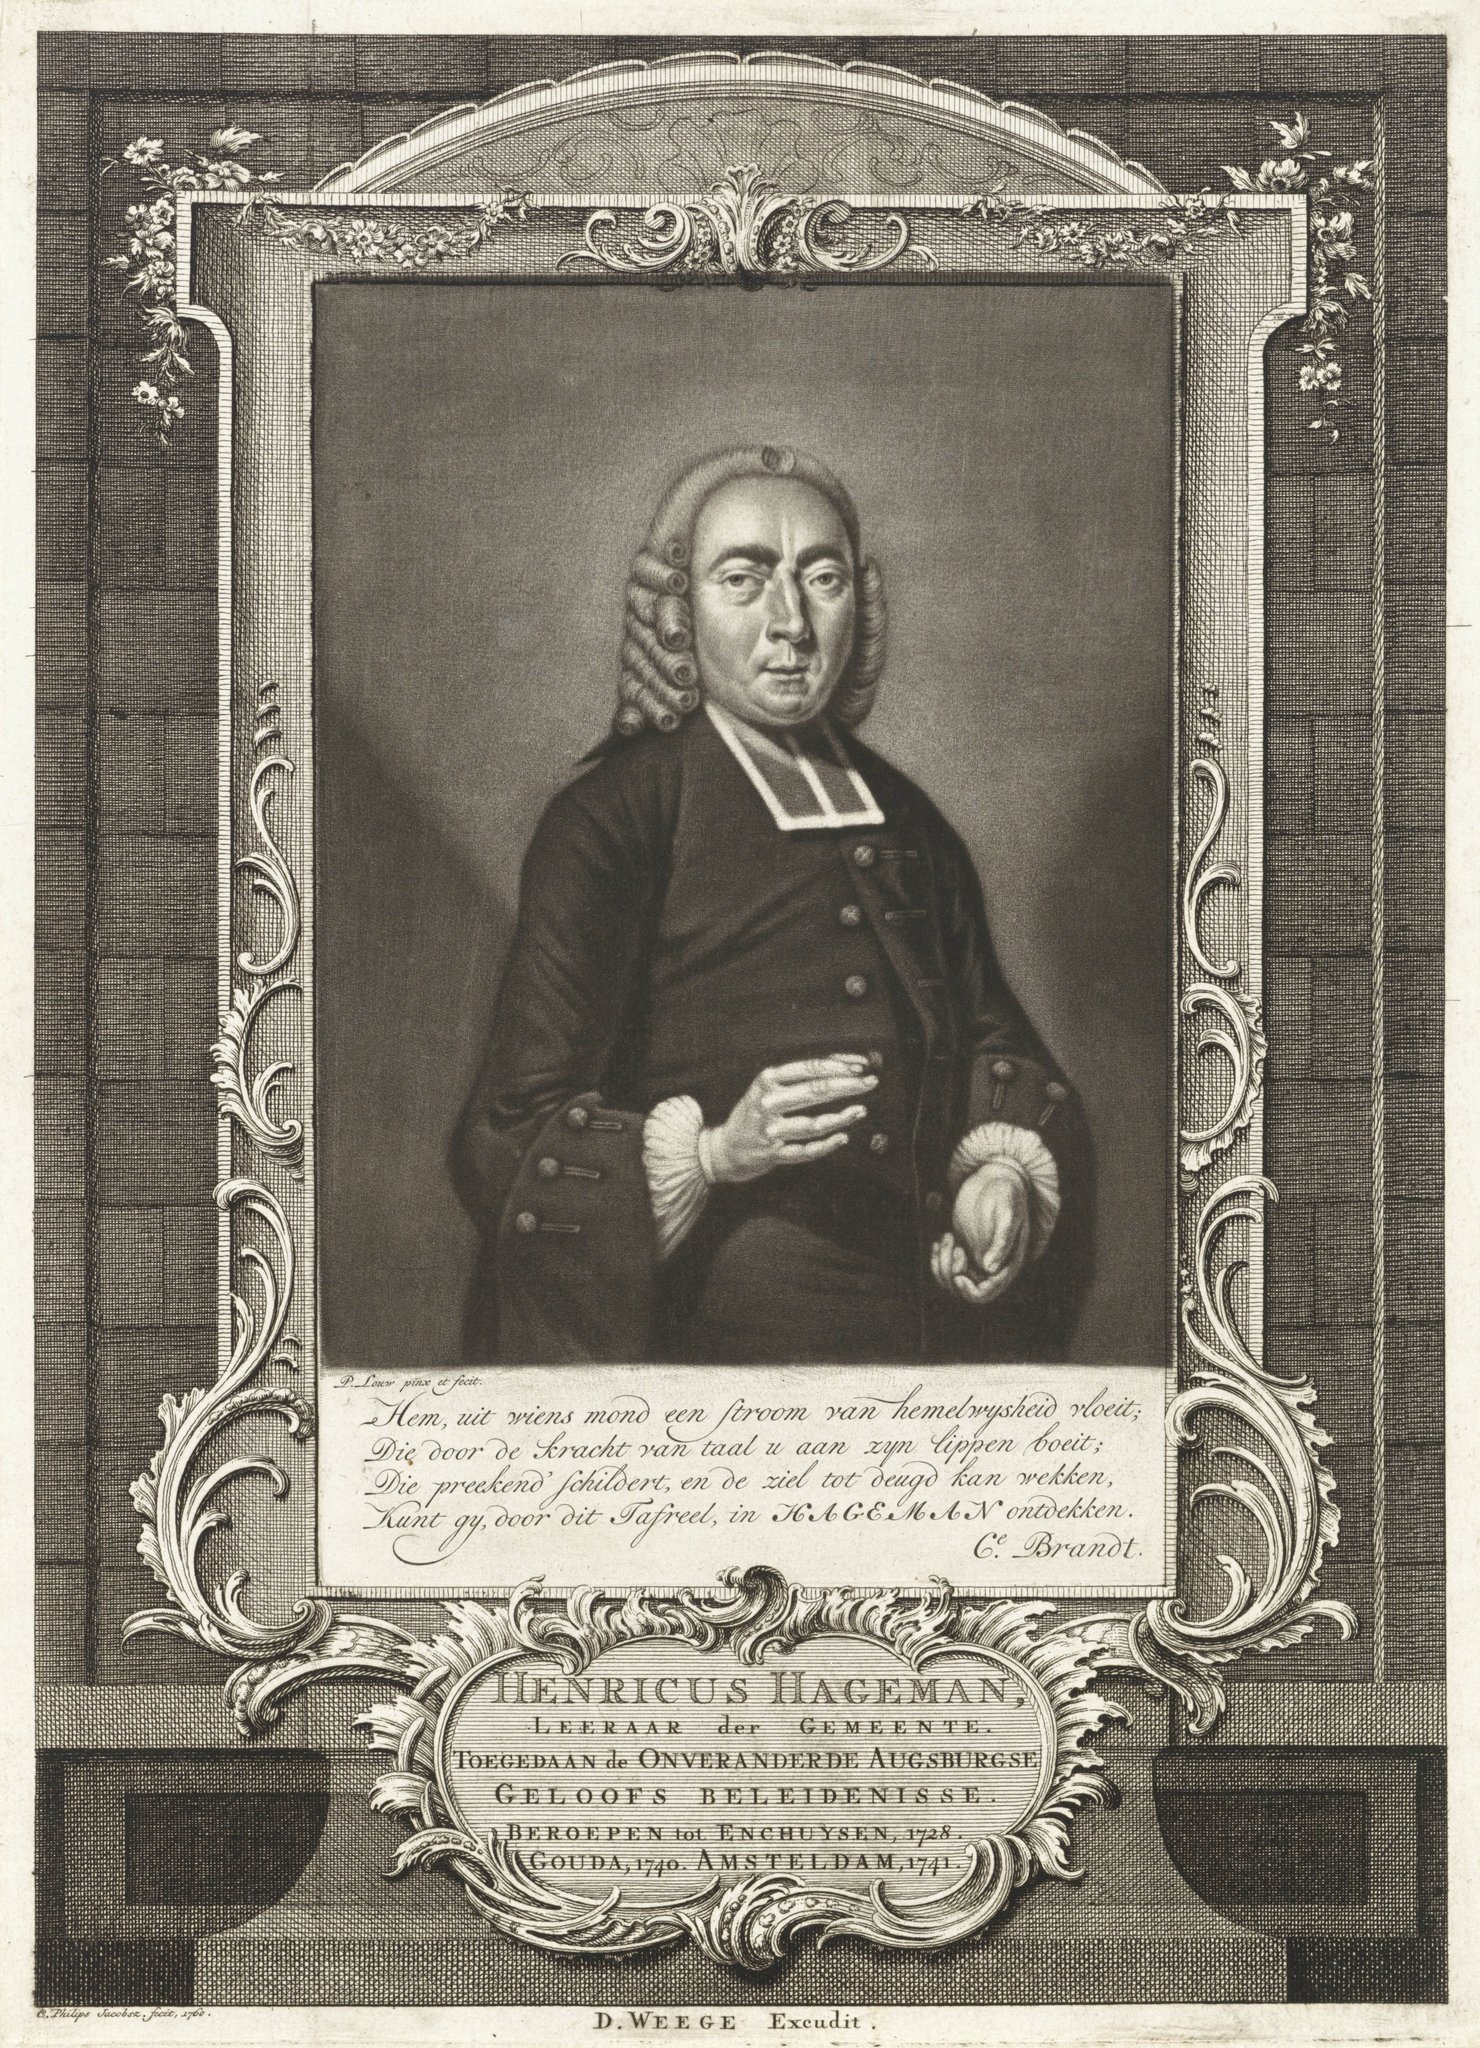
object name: print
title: Portret van de predikant Henricus Hageman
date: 1760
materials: paper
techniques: engraving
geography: amsterdam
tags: amsterdam, wig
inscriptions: date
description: De predikant Henricus Hageman, gevat in een ornamentele omlijsting.